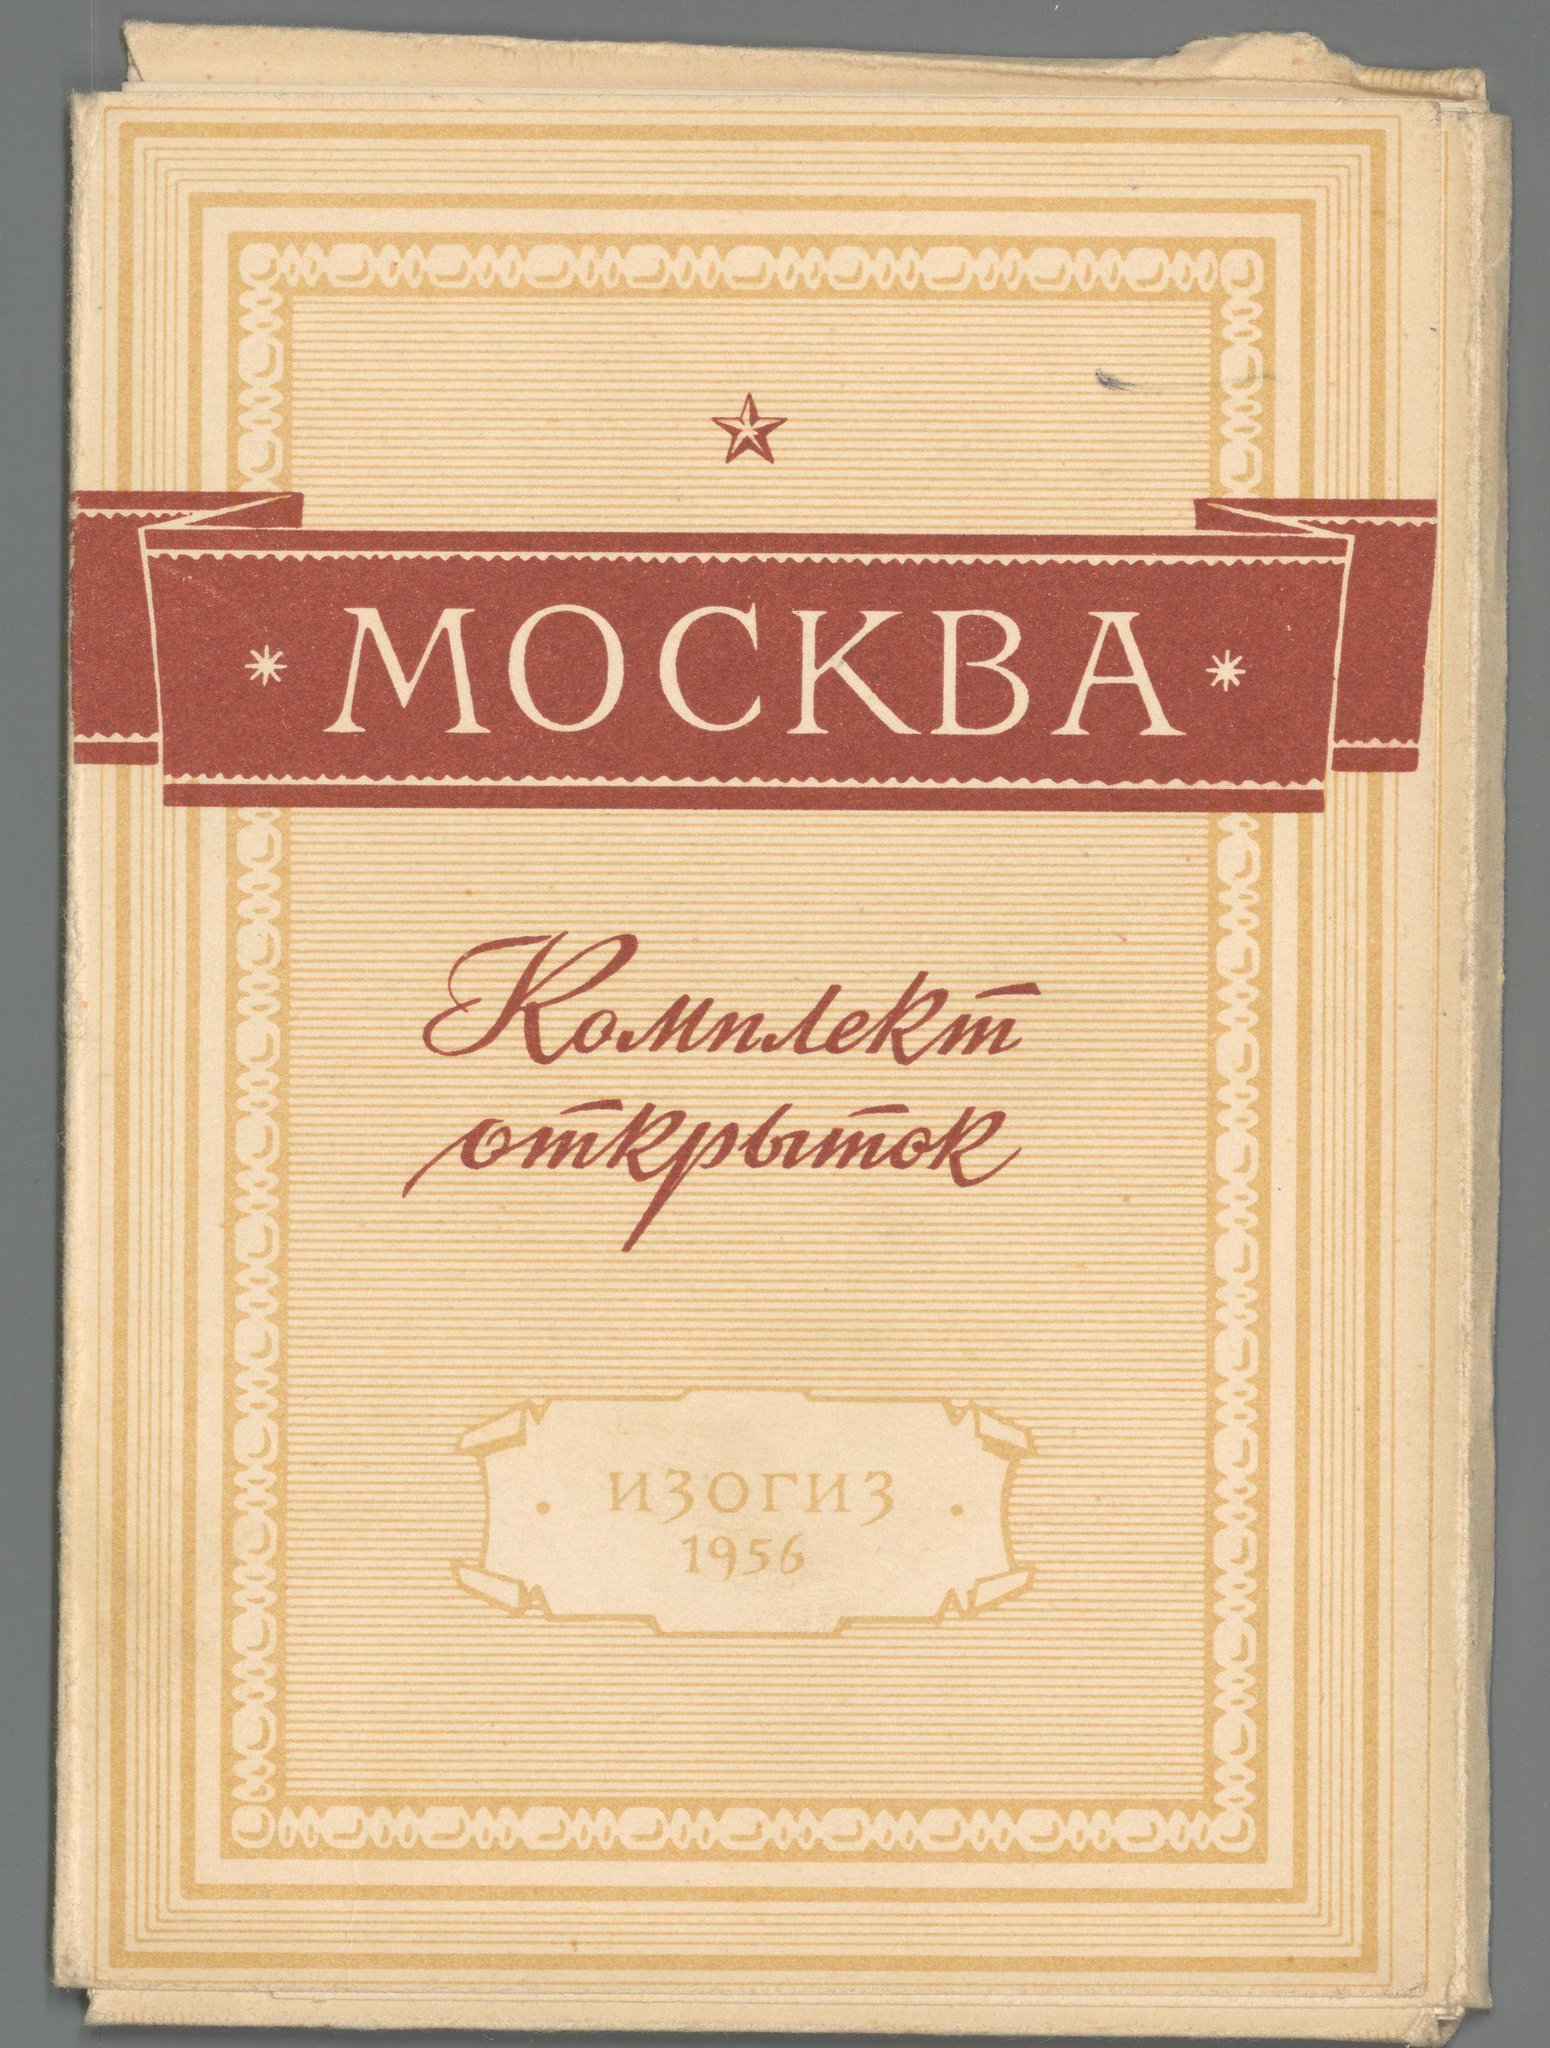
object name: wrapper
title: Omslag voor 24 prentbriefkaarten met gezichten uit Moskou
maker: Anonymous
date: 1956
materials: cardboard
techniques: lithograph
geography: moscow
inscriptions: date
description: De titel op object staat in het Russisch.